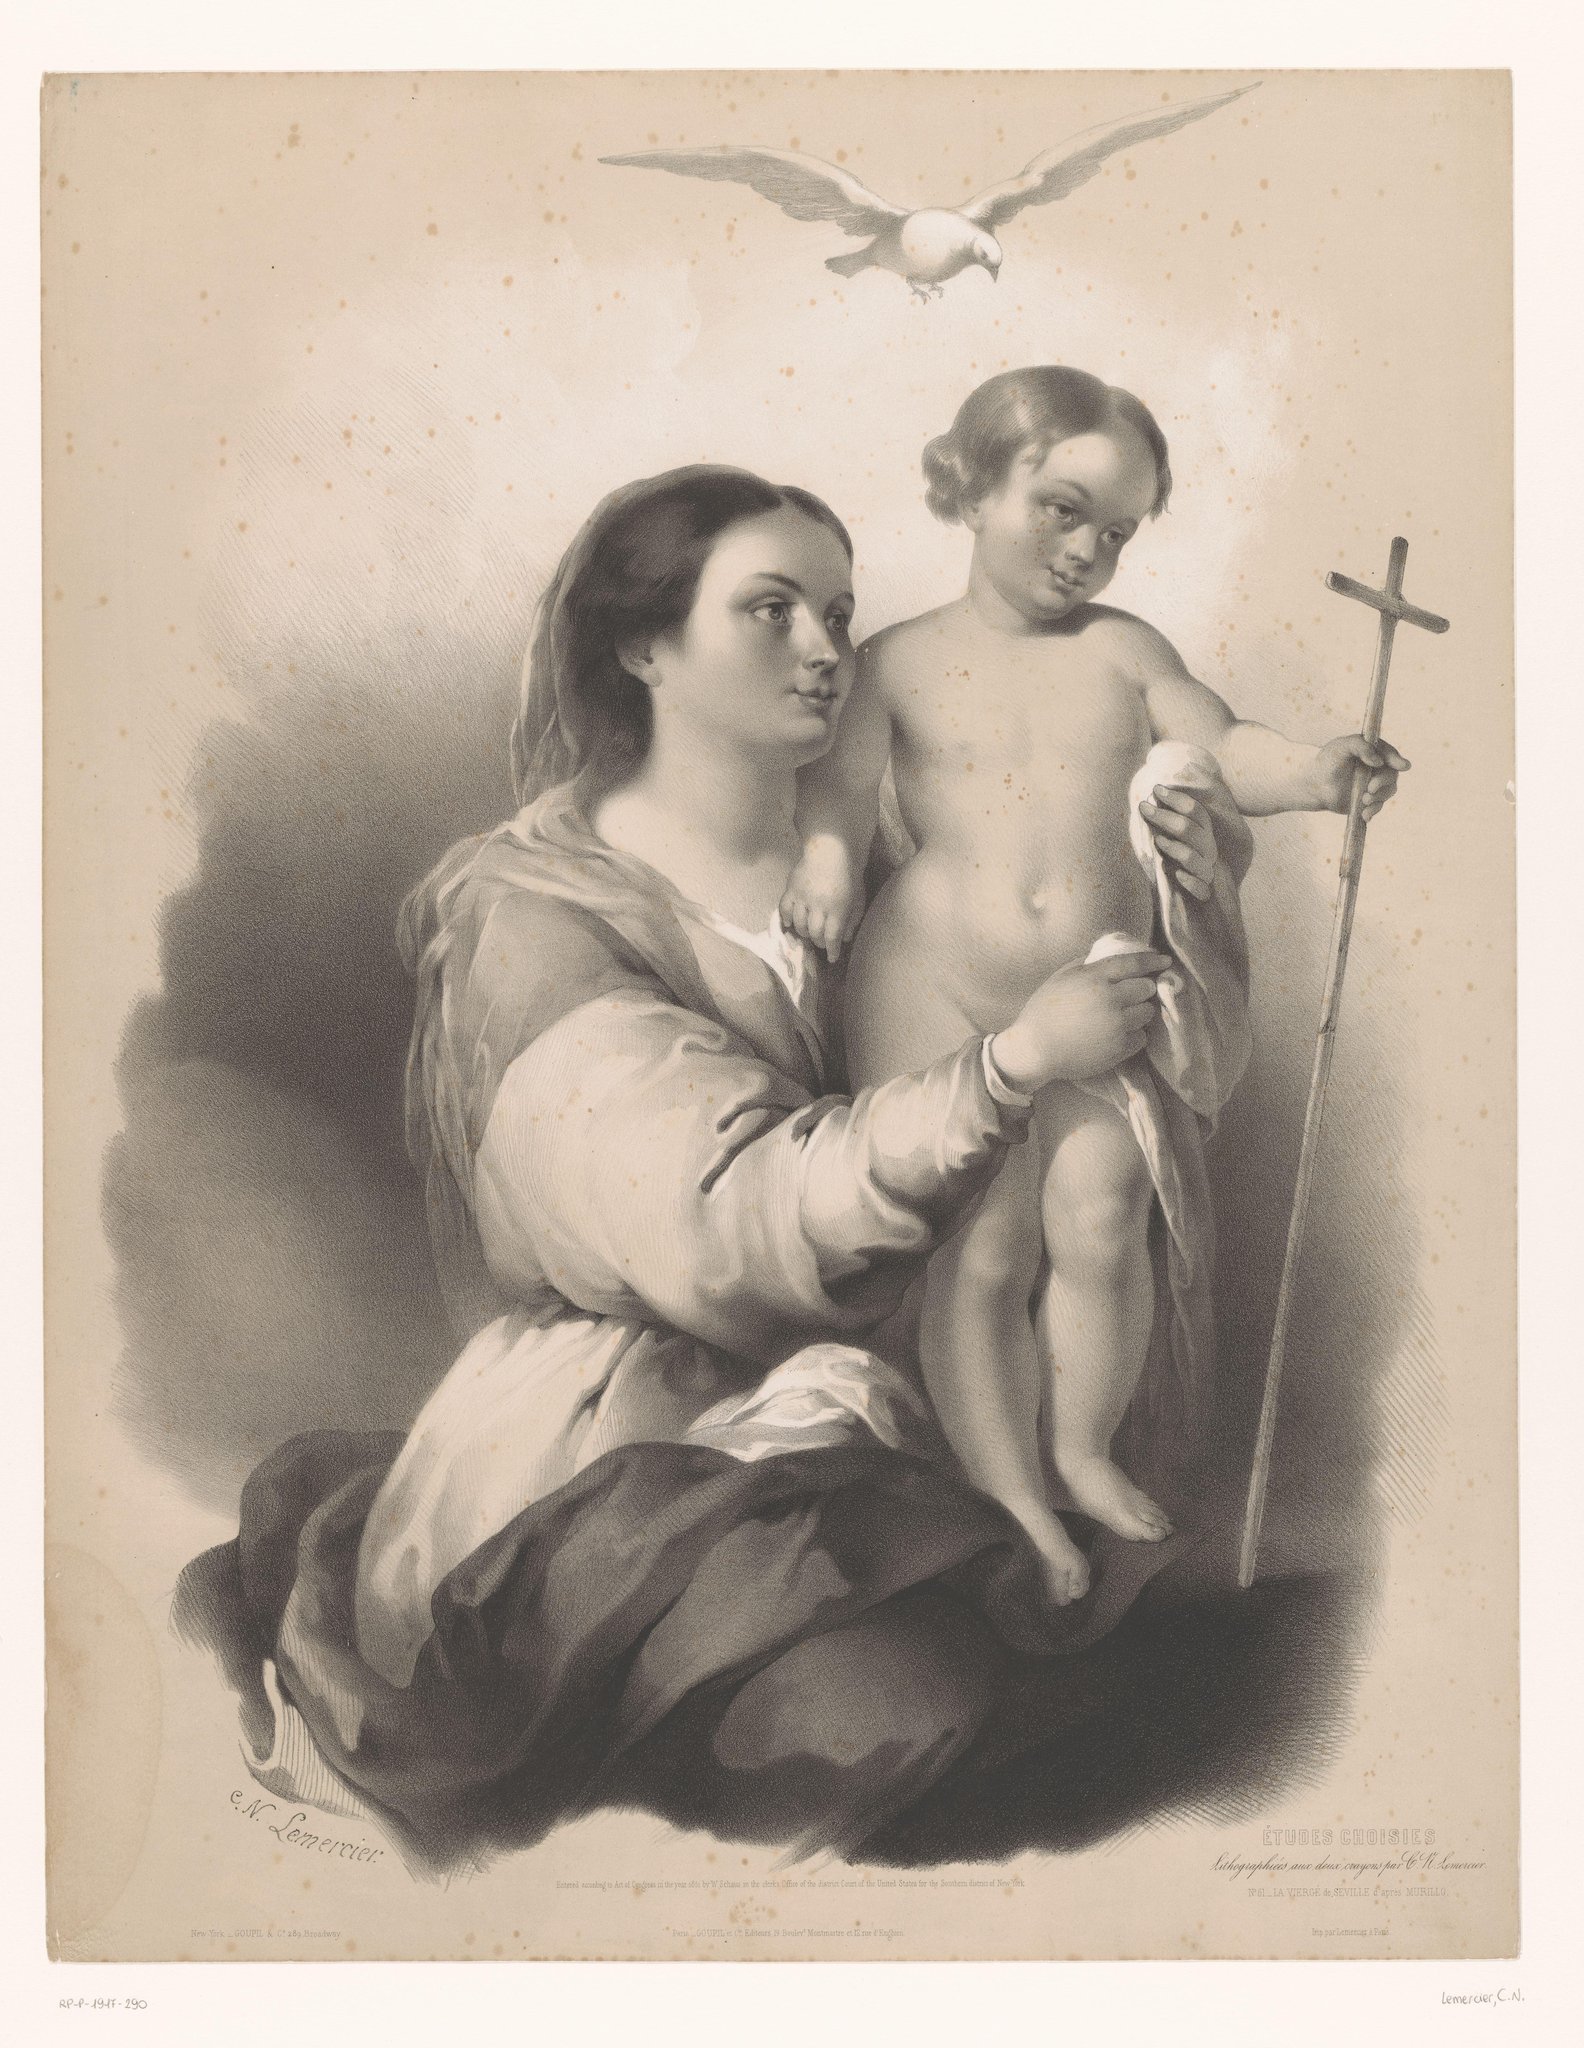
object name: print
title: Études choisies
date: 1851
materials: paper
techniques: tone lithography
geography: paris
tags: madonna: mary sitting or enthroned, the christ-child in her lap (or in front of her bosom) (mary sometimes represented half-length), holy ghost represented as a dove (in flames)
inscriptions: check stamp: Lugt 1090, collector's mark: Lugt 2228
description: W. Schaus registreerde de prent voor het behoud van copyright in de Verenigde Staten.